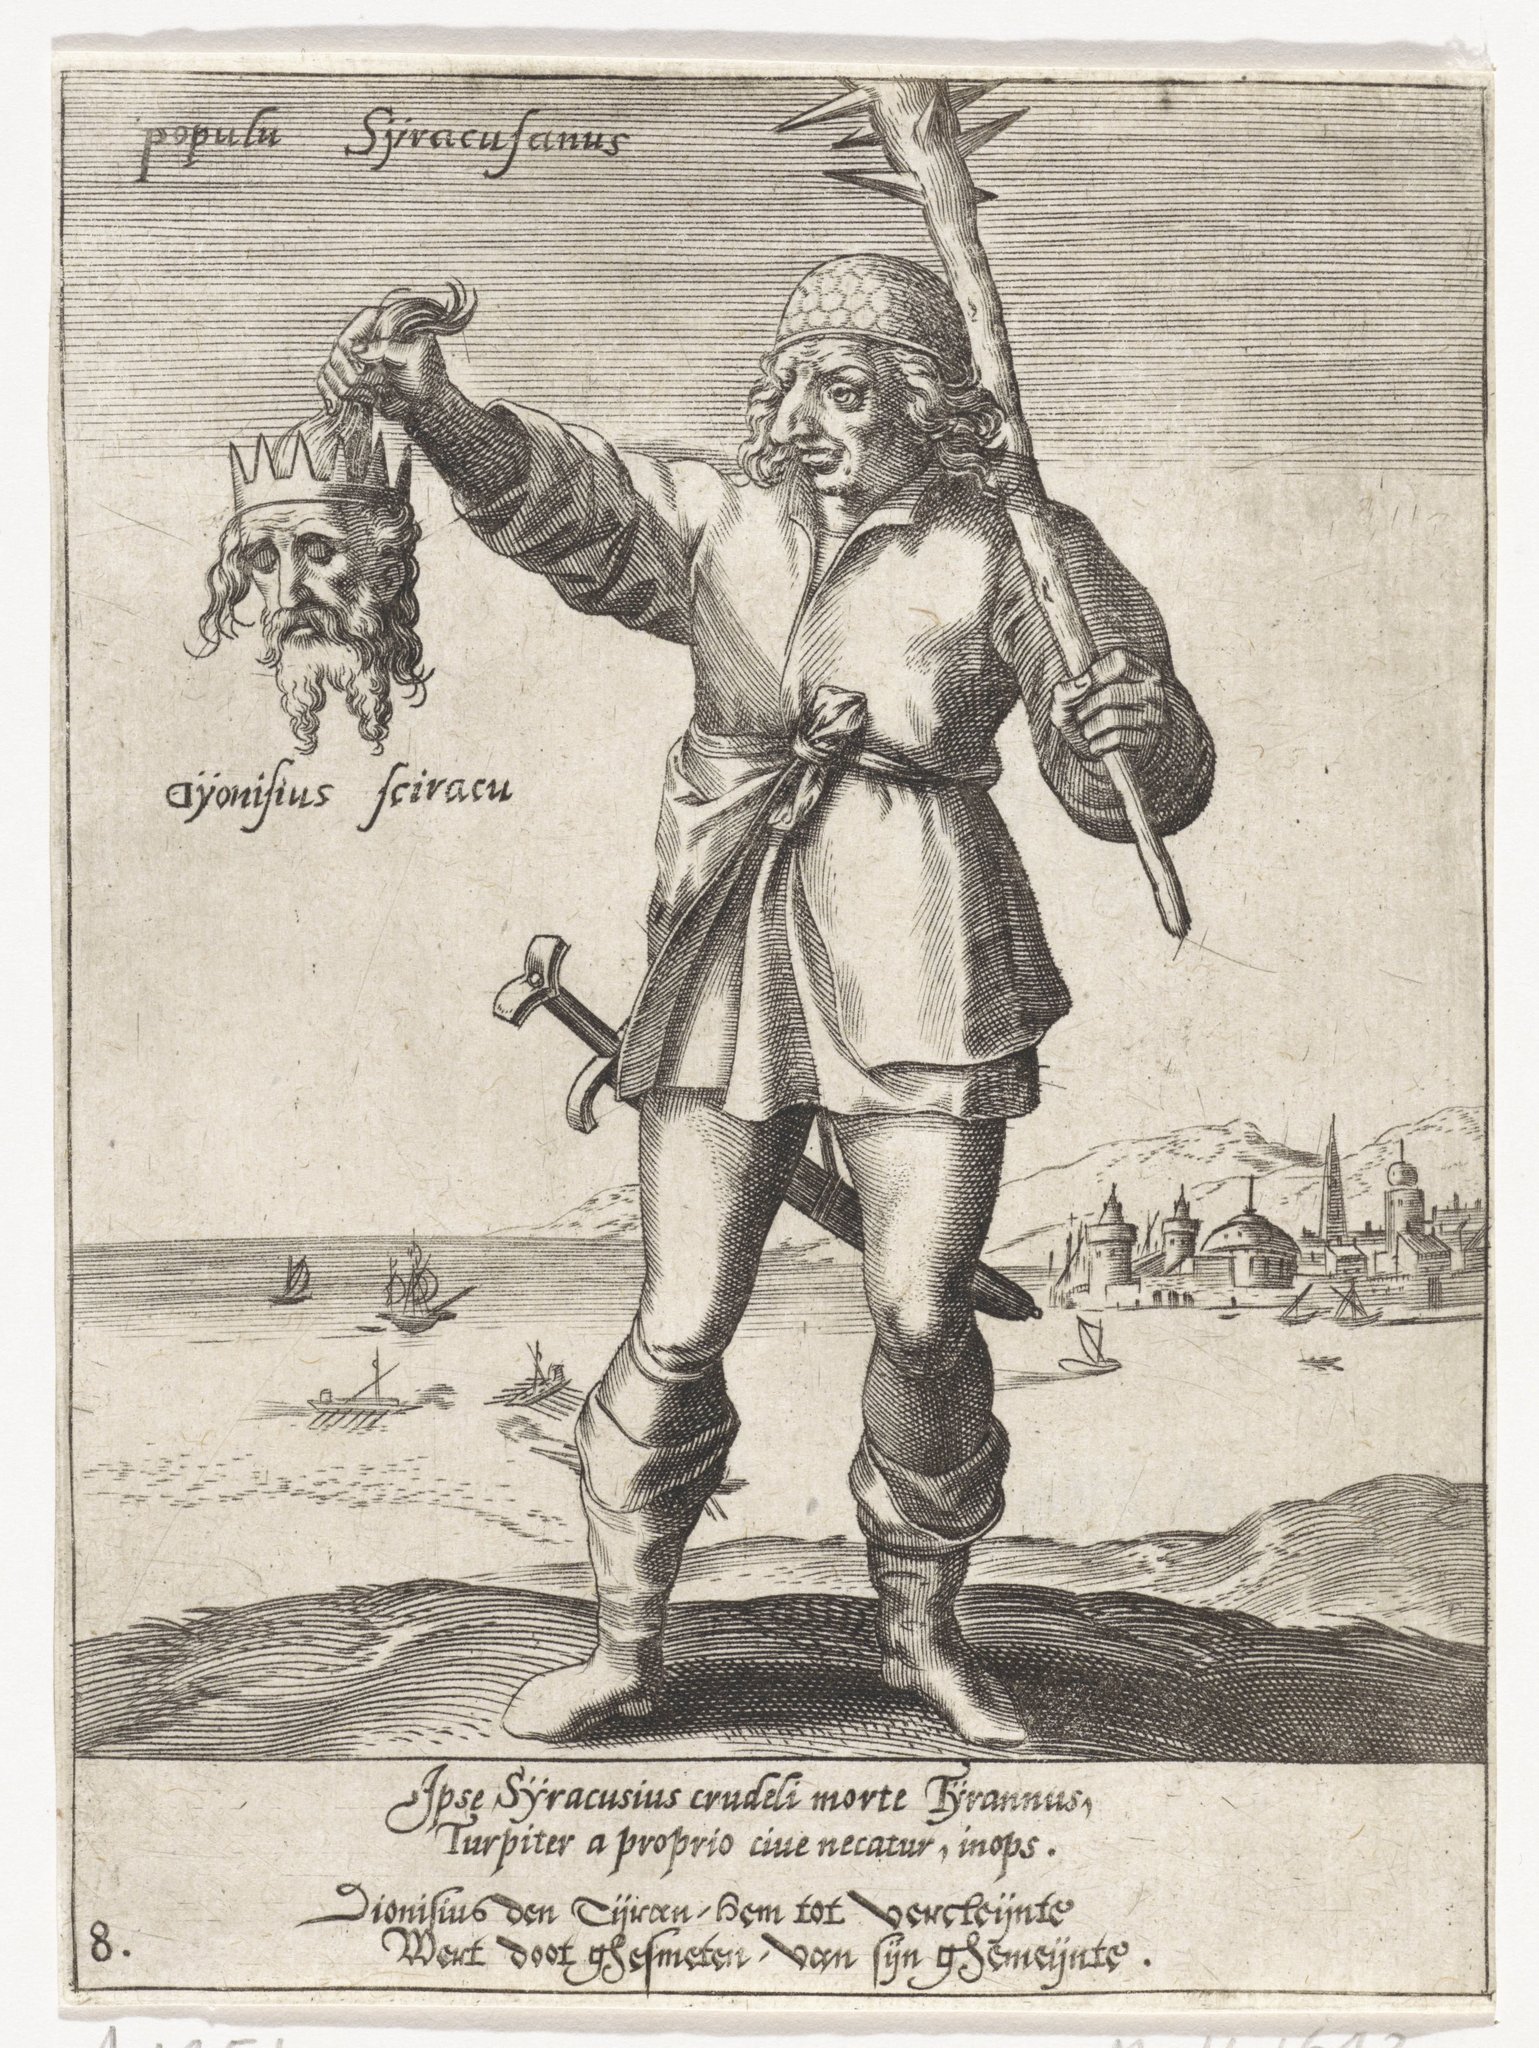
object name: print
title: Helden en heldinnen uit de bijbel en de klassieke oudheid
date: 1578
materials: paper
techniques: engraving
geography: antwerp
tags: violent death by beheading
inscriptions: collector's mark: Lugt 2228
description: Landschap met een anonieme man. In zijn hand het hoofd van Hiëronymus de tiran, de koning van Syracuse, over wie Livius vertelt dat hij door zijn eigen manschappen in een nederlaag werd gelokt. In de marge een tweeregelig onderschrift in het Latijn en in het Nederlands.